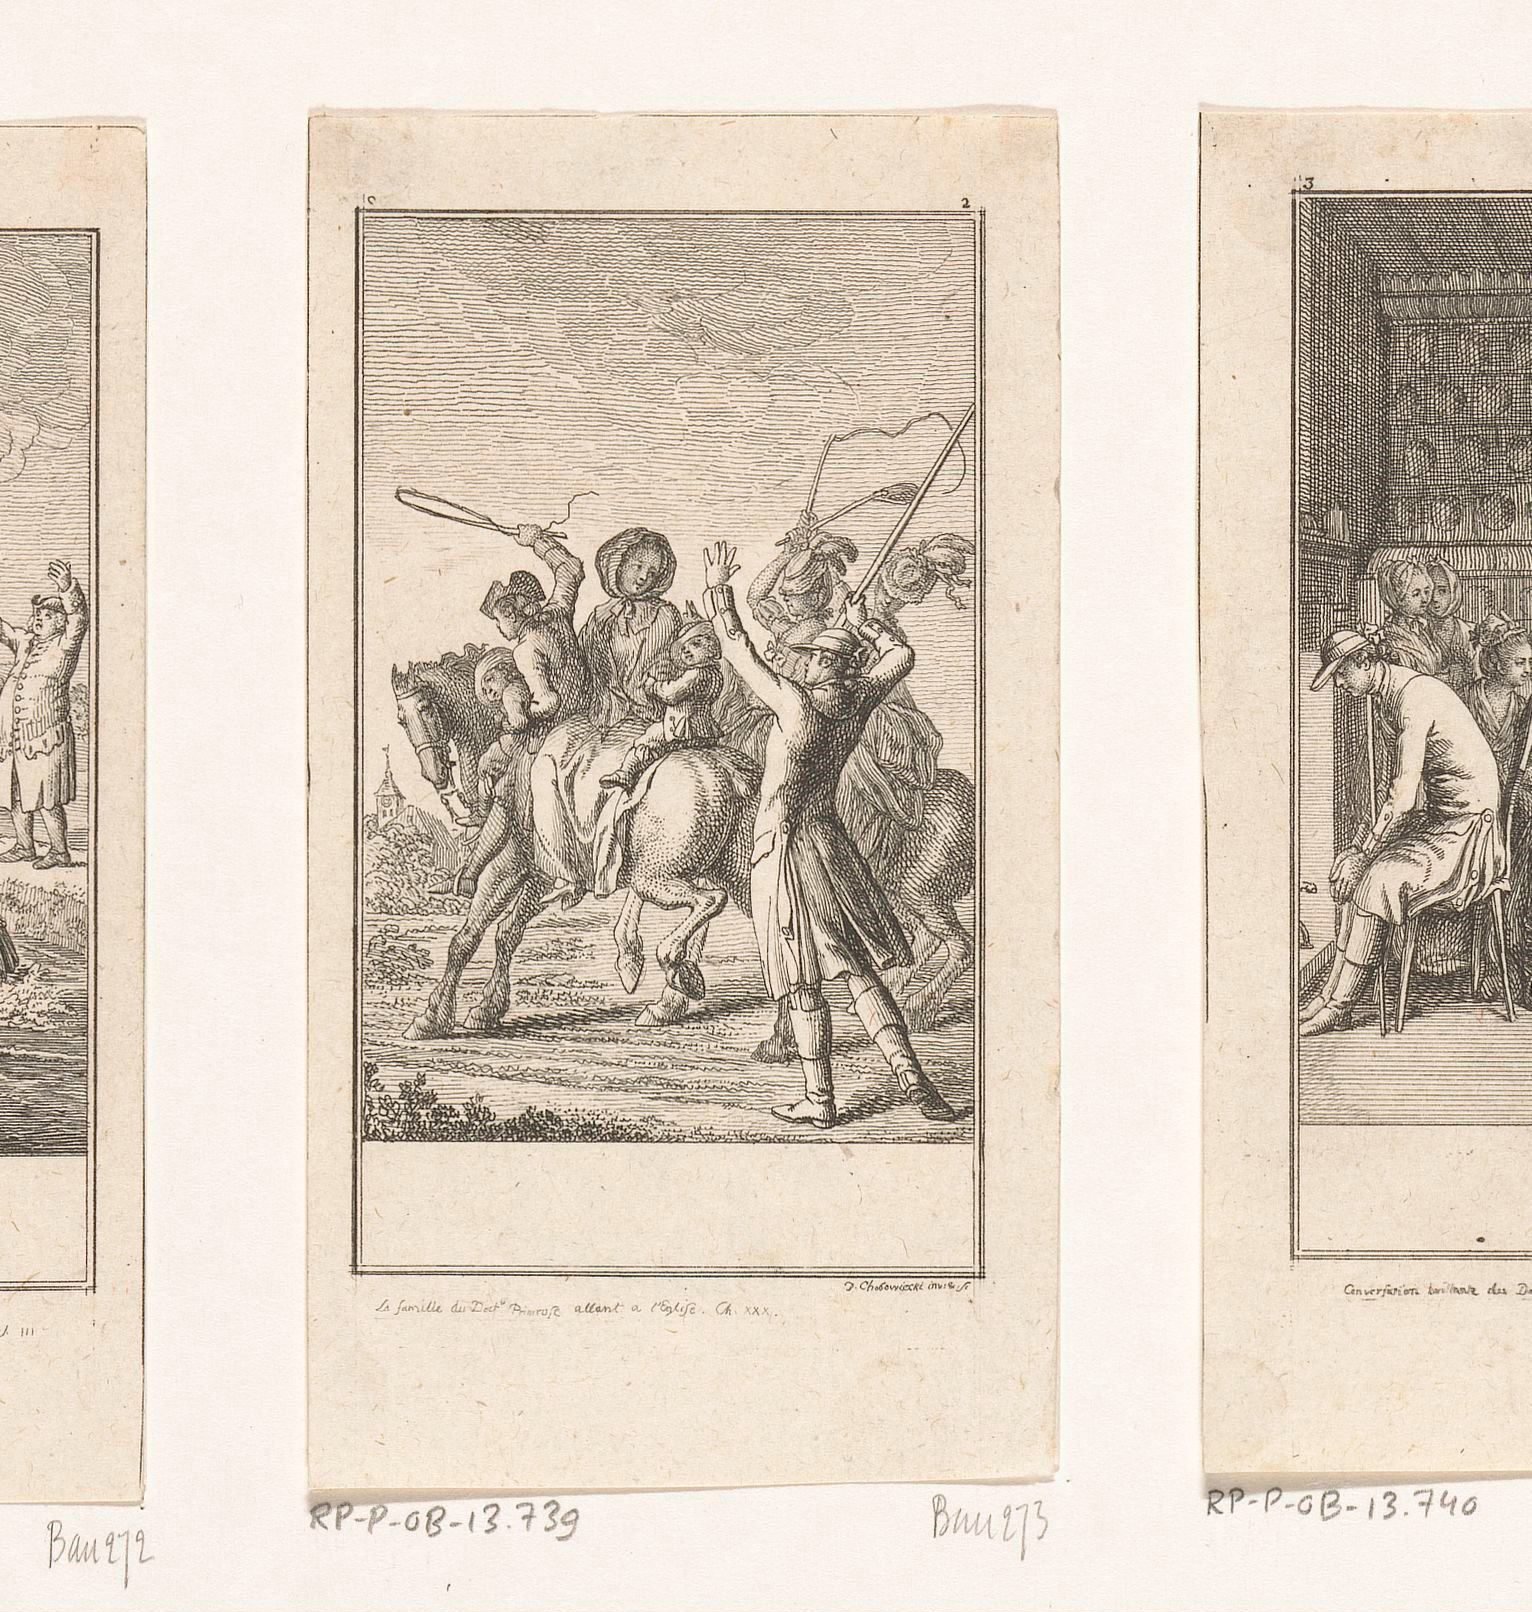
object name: print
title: La famille du Doctr Primrose allant a l'Eglise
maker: daniel nikolaus chodowiecki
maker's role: draughtsman, print maker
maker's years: 1726-1801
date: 1776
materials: paper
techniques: etching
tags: london, oliver goldsmith, (goldsmith, the vicar of wakefield) specific works of literature (with author, title)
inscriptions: collector's mark: Lugt 2228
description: De familie van Charles Primrose probeert zich voor doen omdat dochter Olivia in de belangstelling staat van Squire Thornhill. Er wordt besloten om in plaats van te voet, te paard naar de kerk te gaan. Het oude dier heeft echter te weinig kracht om alle familieleden te dragen. Mr. Burchell schiet te hulp en slaagt er in het halsstarrige paard in beweging te krijgen. Rechtsboven genummerd: 2.